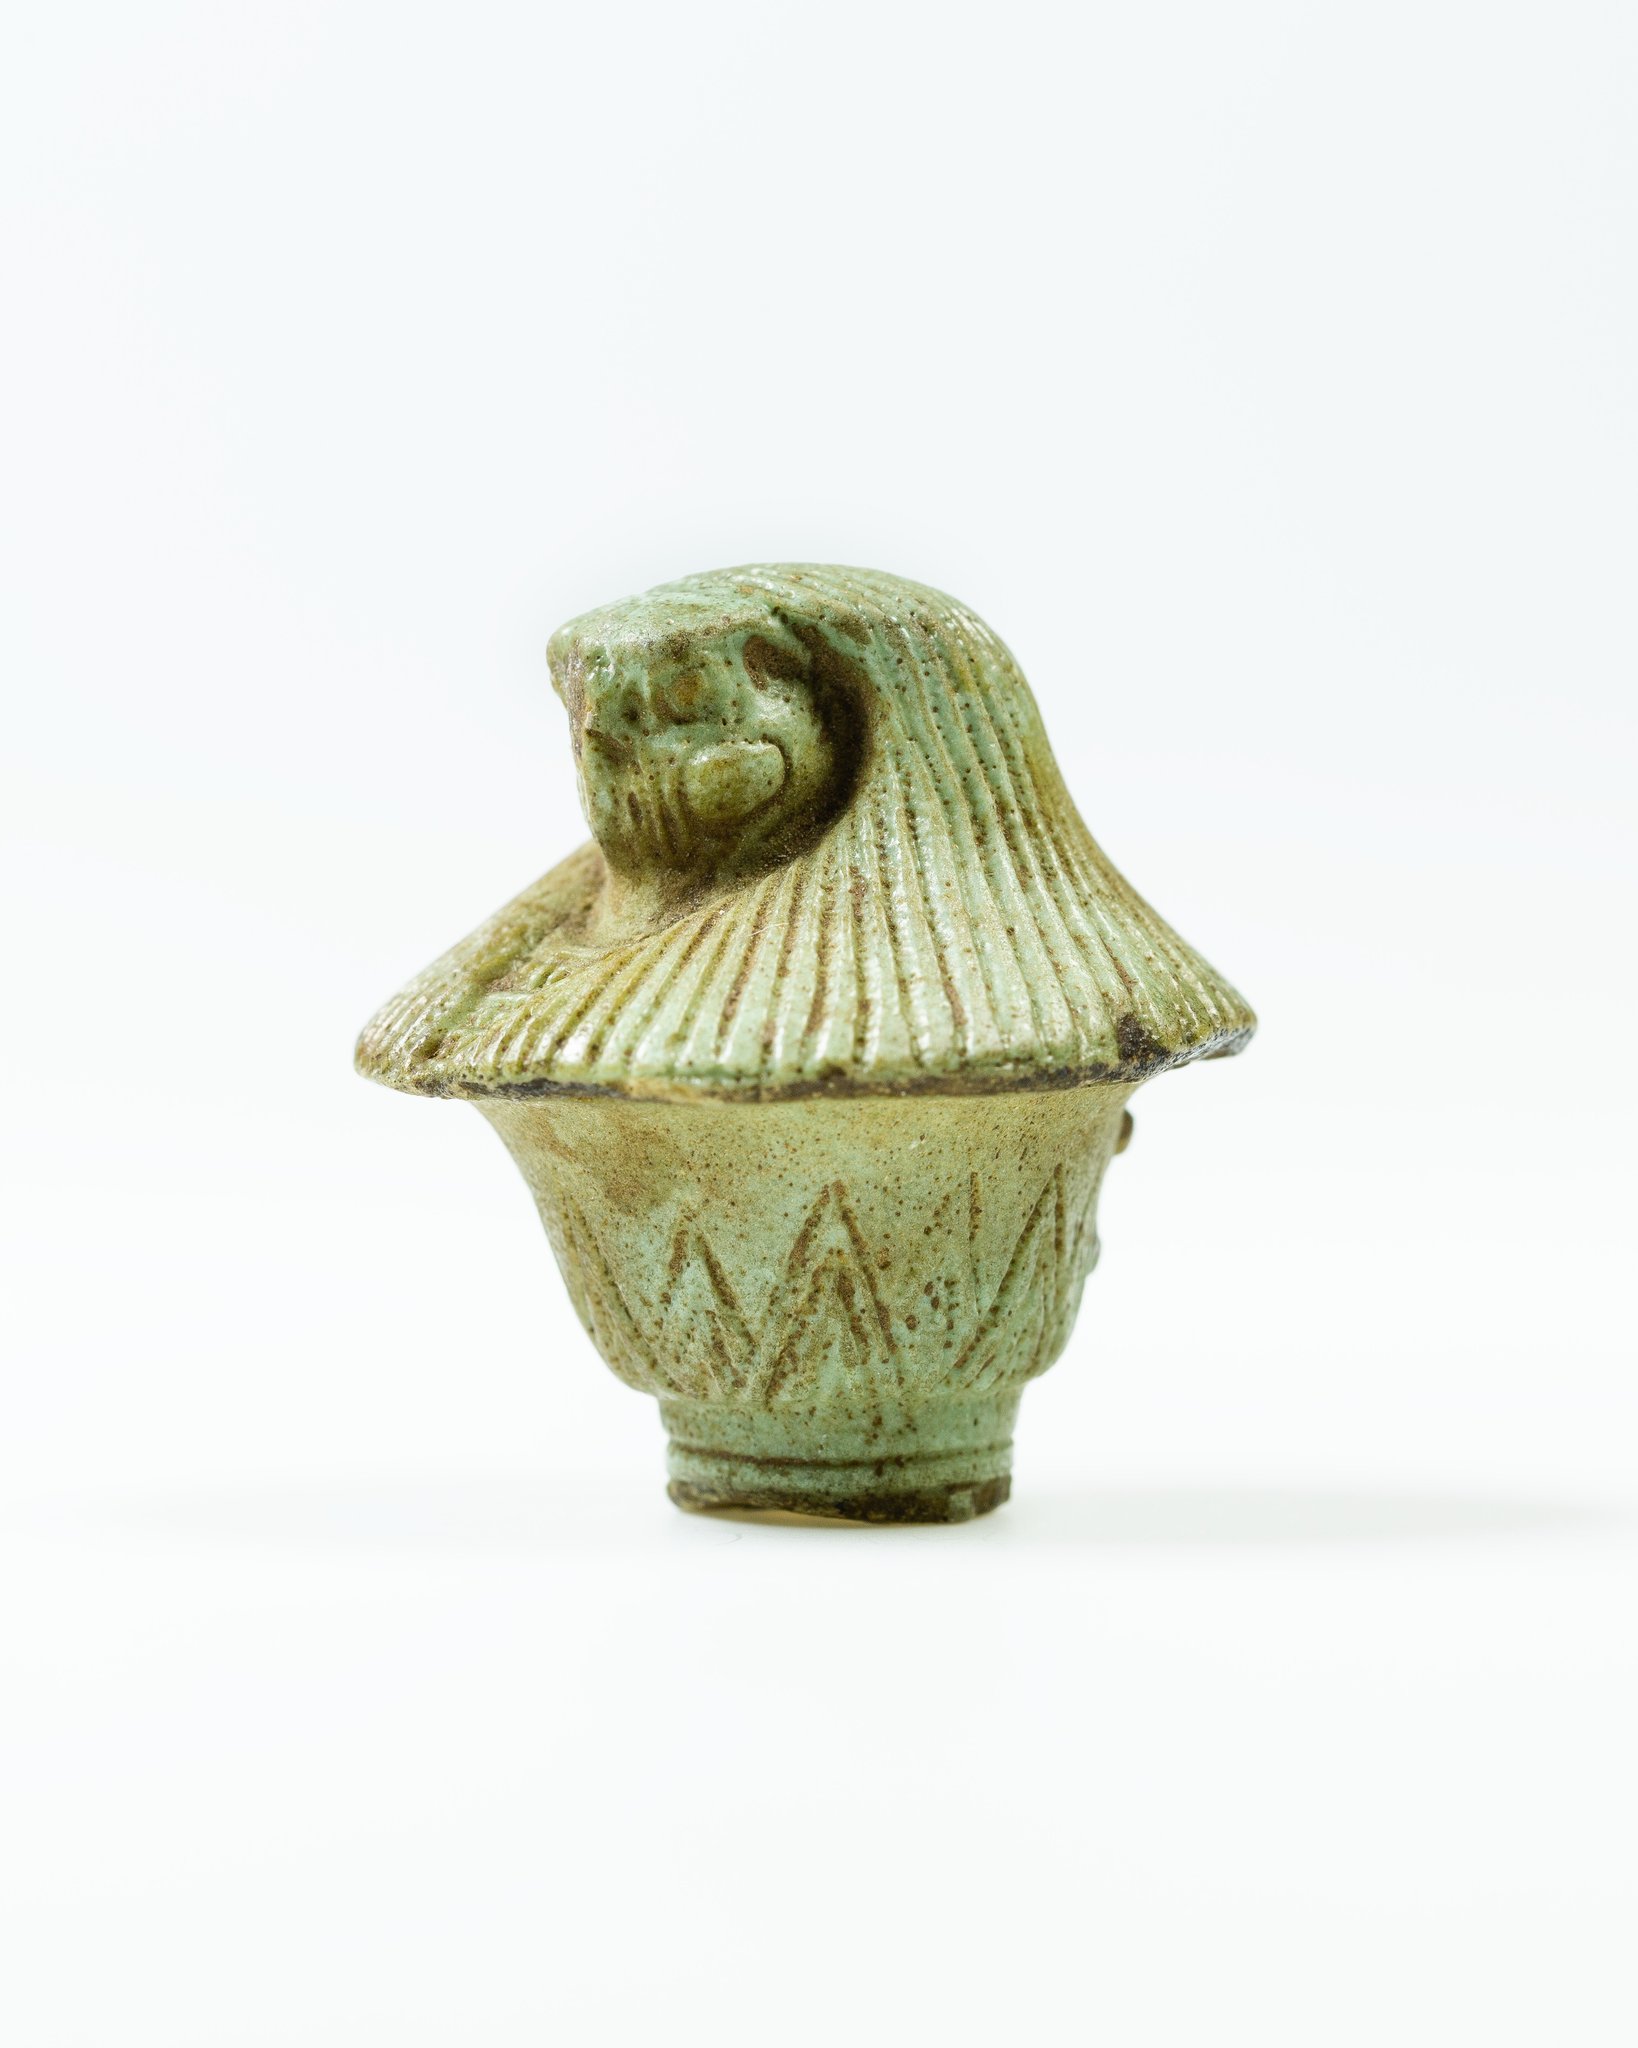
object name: top of papyrus scepter amulet with falcon head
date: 1086 BCE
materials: faience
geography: egypt